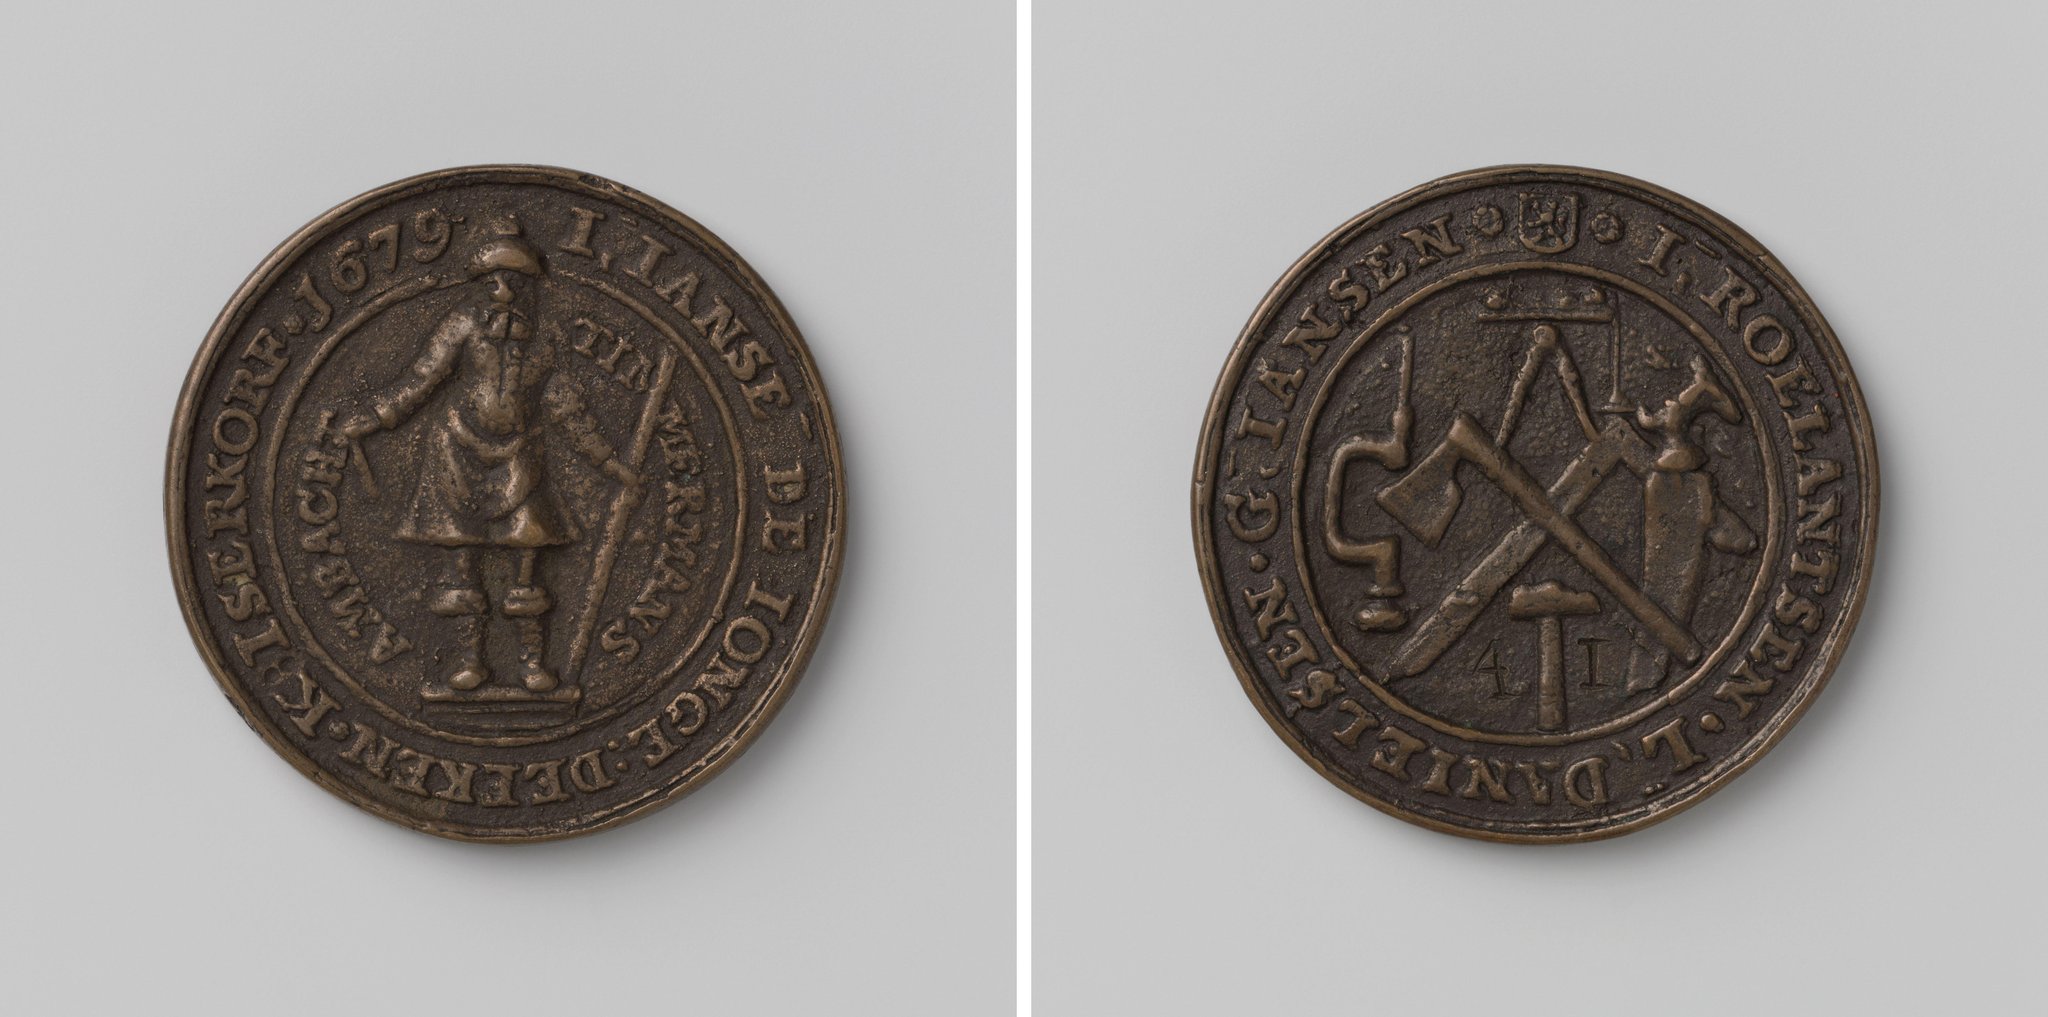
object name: medal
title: Timmerliedengilde van Zierikzee, gildepenning met no. 41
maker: johannes de laedt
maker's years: 1657-1709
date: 1679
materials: copper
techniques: casting, engraving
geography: zierikzee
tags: i. janse de jonge, k. iserkorf, i. roelantsen, l. danielsen, g. jansen (timmerman), zierikzee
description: Koperen penning. Voorzijde: St. Jozef met tulband op hoofd, staande op voetstuk; in rechterhand een geopende passer, in linkerhand een maatstok binnen tweeregelig omschrift. Keerzijde: boor, bijl, winkelhaak, zaag, paslood, passer en hamer boven cijfer 41 binnen tweeregelig omschrift